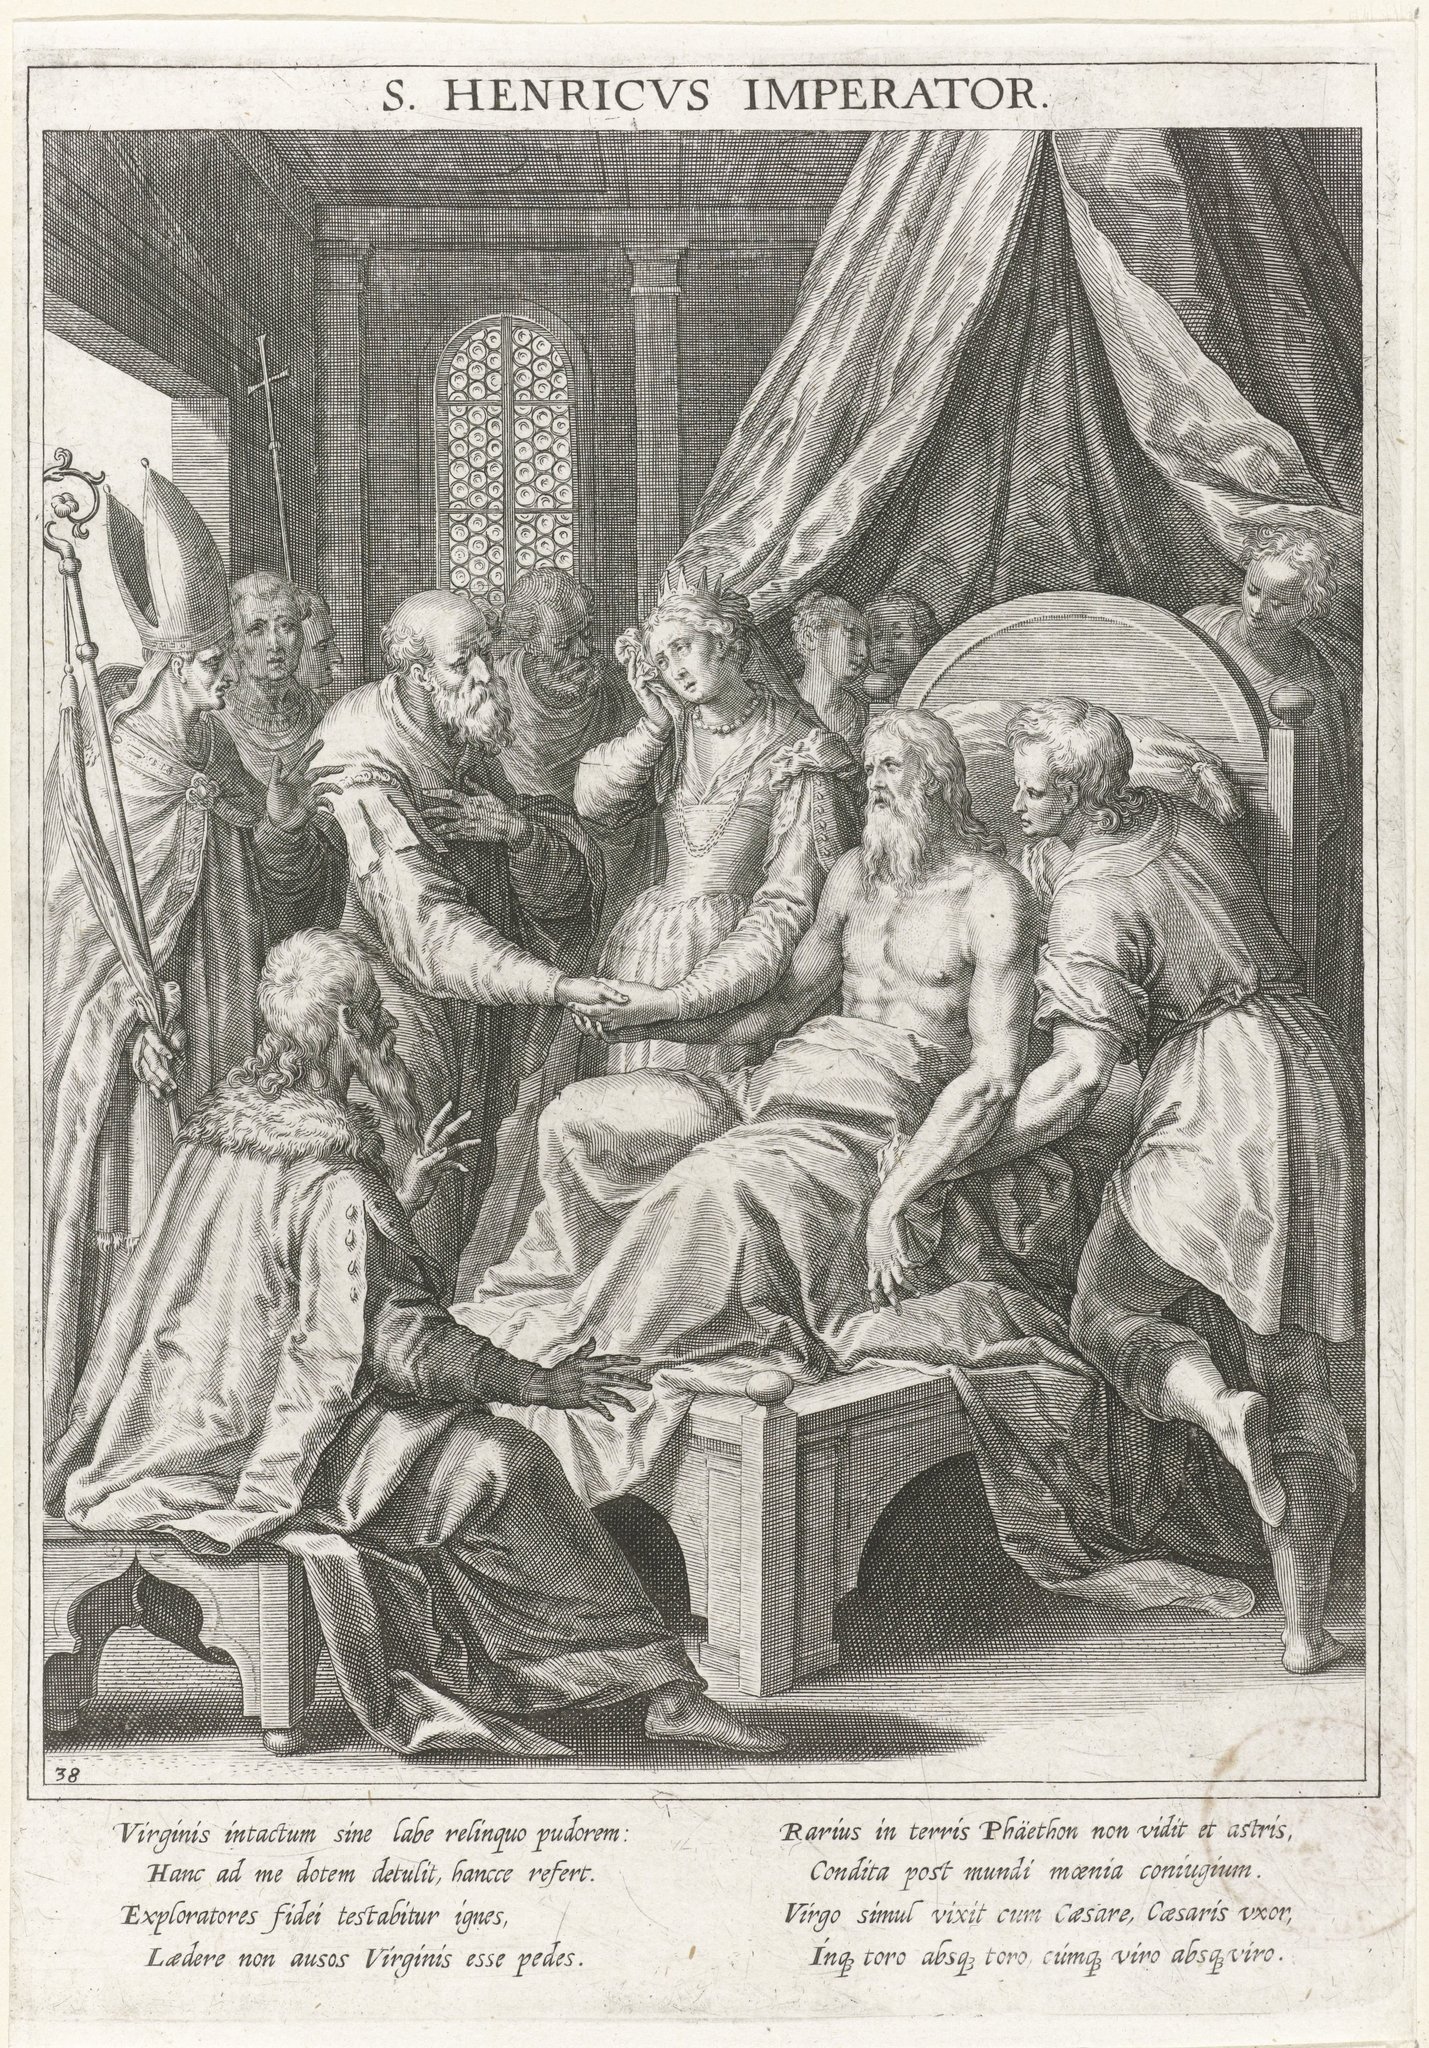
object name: print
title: S. Henricvs imperator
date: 1615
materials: paper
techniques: engraving, etching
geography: munich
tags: cunegunda of bamberg, wife of henry ii, king of germany; possible attributes: crown, model of church, ploughshare, sceptre - non-miraculous activities and events ~ female saint, death, deathbed of st. henry, deathbed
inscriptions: collector's mark: Lugt 240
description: Keizer Hendrik II de Heilige ligt op zijn sterfbed. Hij vertelt zijn hovelingen dat zijn vrouw, de H. Cunegundes van Luxemburg, nog maagd is en na zijn dood niet mag hertrouwen. De prent heeft een Latijns onderschrift en is de 38ste prent van een 60-delige serie met als onderwerp de heiligen van Beieren.